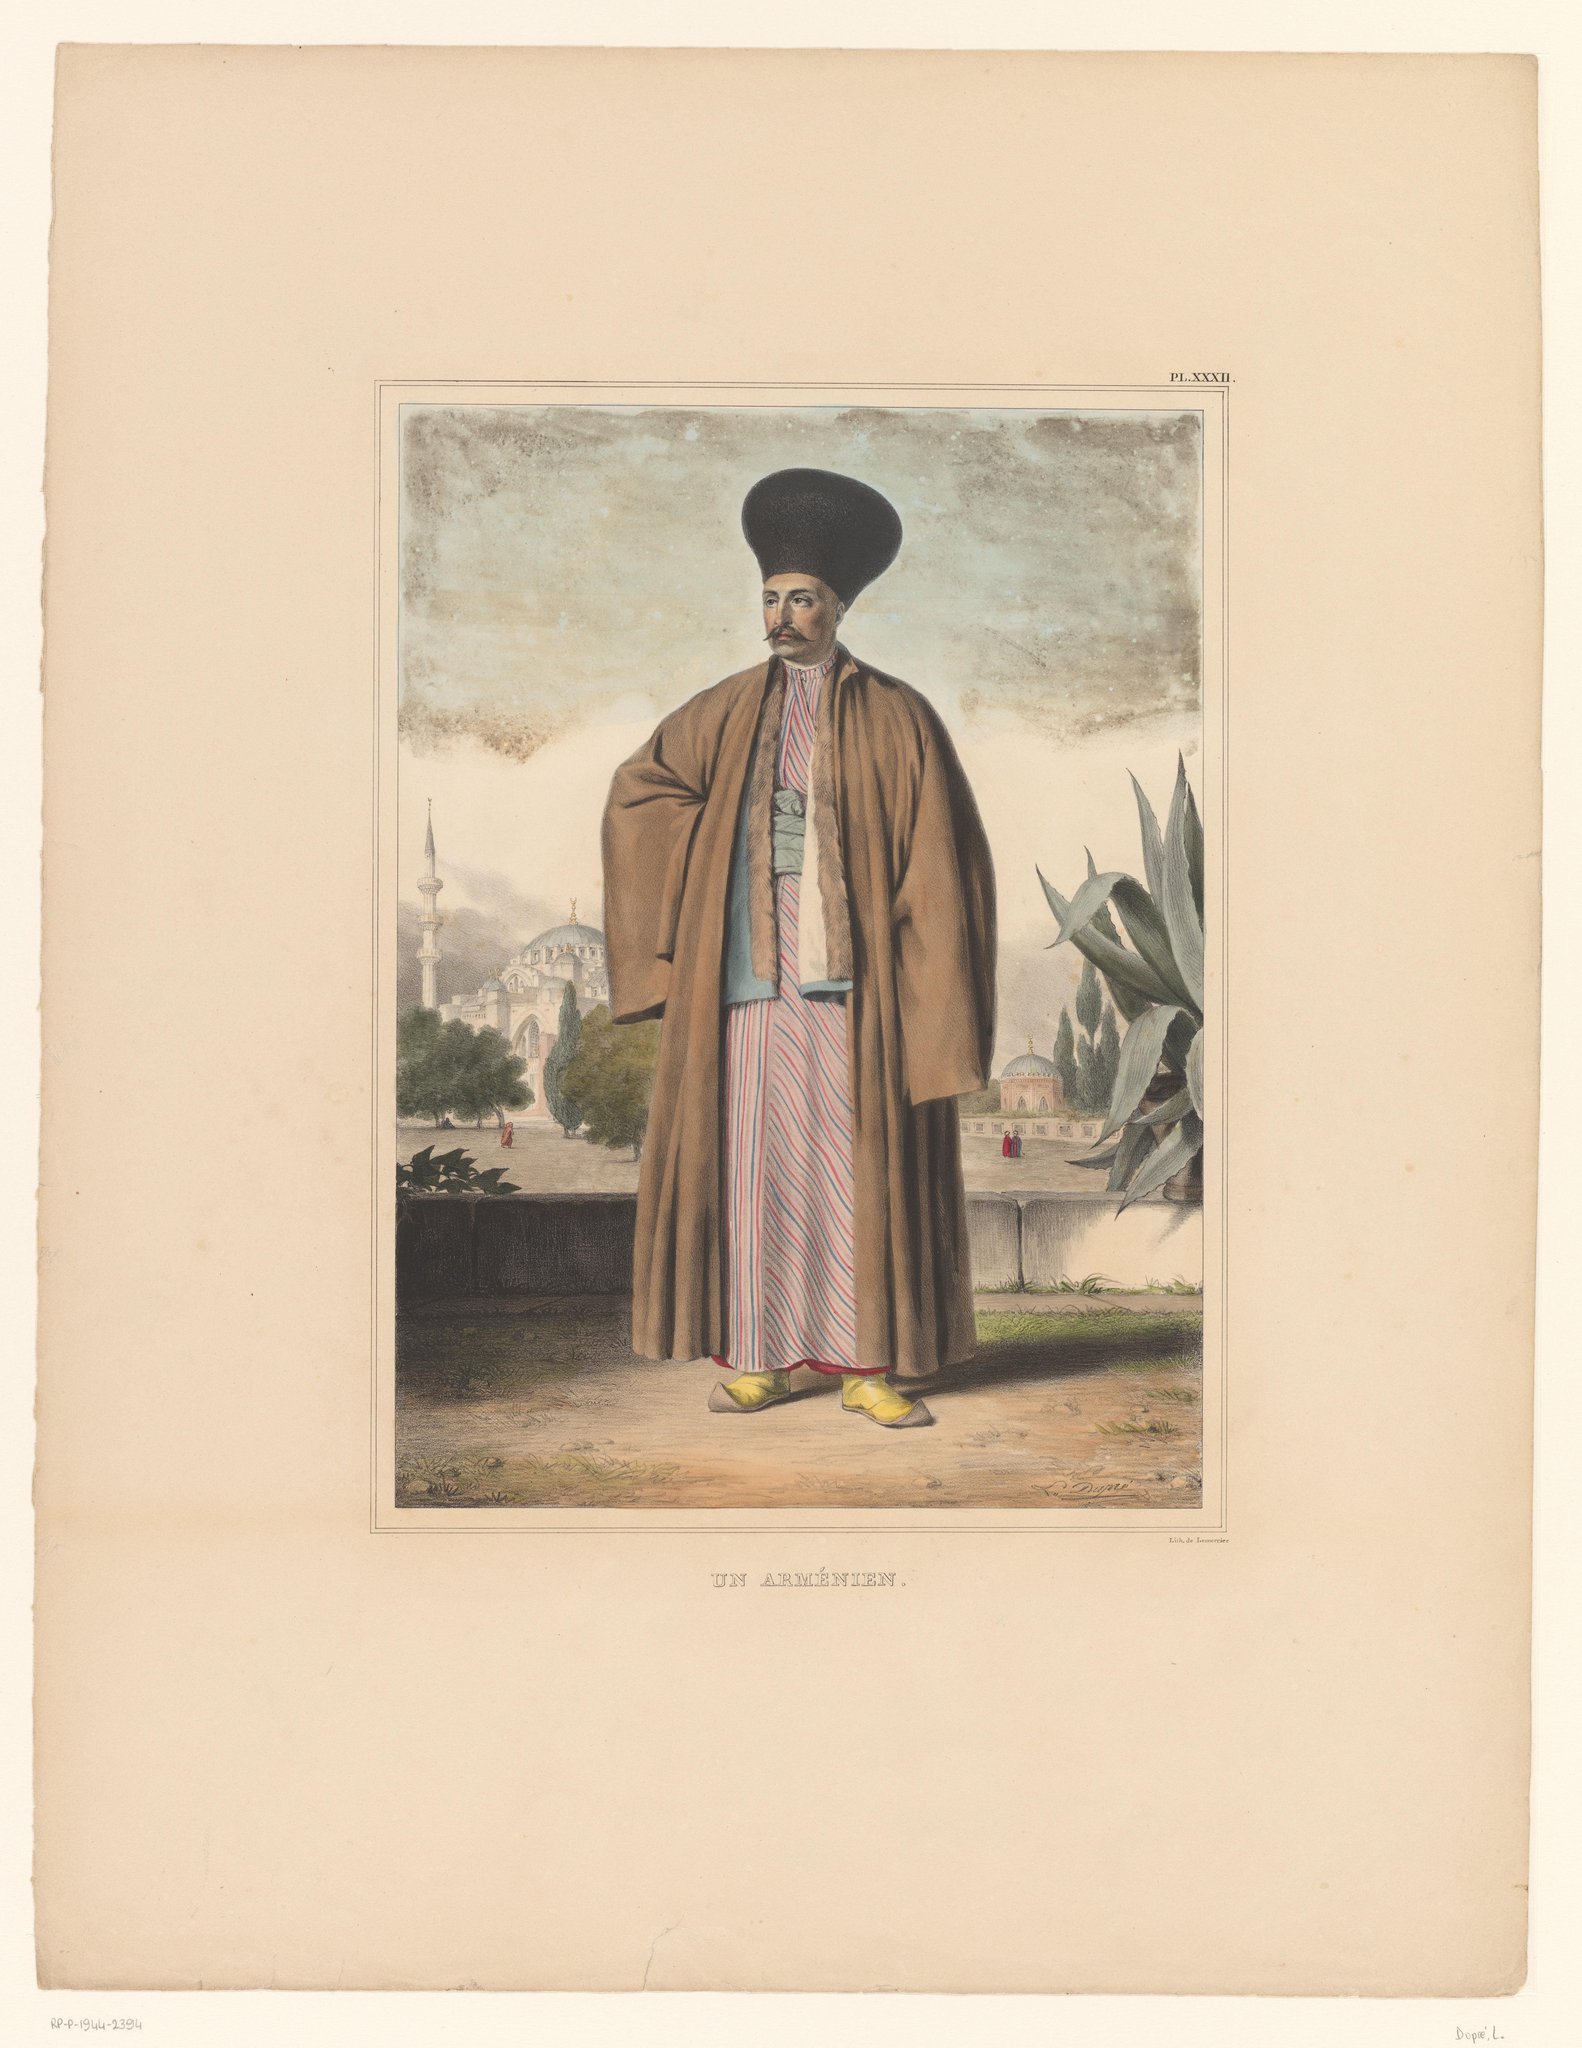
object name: print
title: Un arménien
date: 1828-1839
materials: paper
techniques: hand coloring, lithograph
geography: paris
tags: head-gear, human races, peoples and nationalities (other than prehistoric or extinct)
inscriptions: collector's mark: Lugt 2228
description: De prent maakt deel uit van de serie 'Voyage à Athènes et à Constantinople ou collection de portraits, de vues et de costumes Grecs et Ottomans' die tussen 1825 en 1839 in tien delen van vier prenten werd uitgebracht. De in totaal veertig prenten dienden samen met een tekst van 52 pagina's voorzien van vignettes als een verslag van de reis die Louis Dupré in 1819 naar Athene en het huidige Istanboel maakte (zie documentatie).